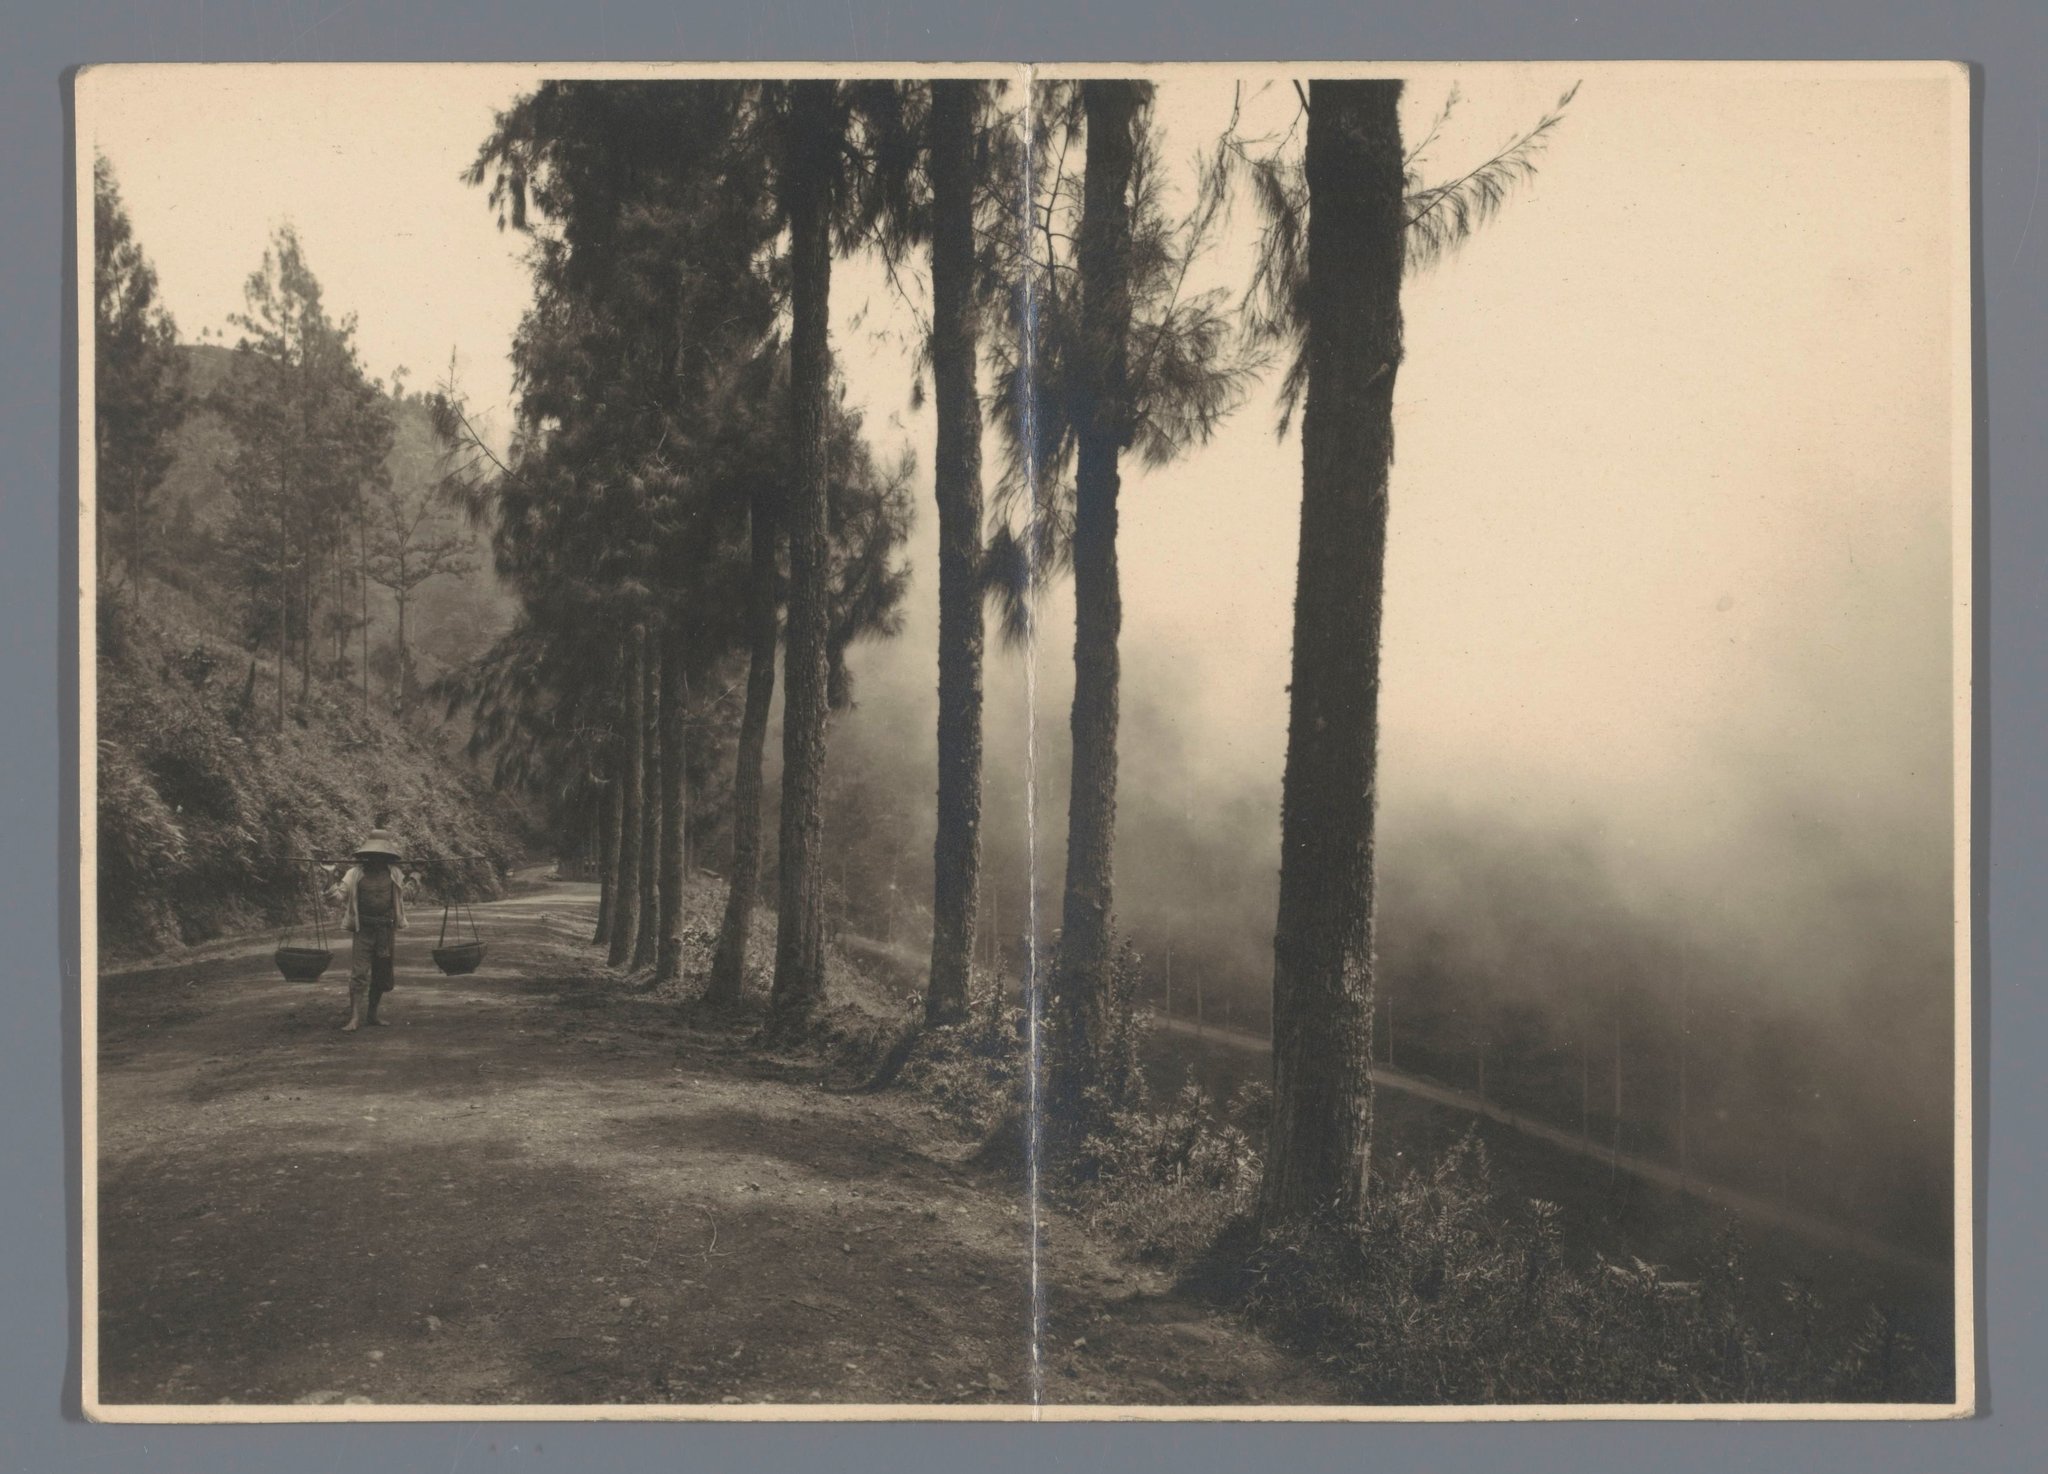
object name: photograph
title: Gezicht op een weg door een berglandschap in Japan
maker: s. satake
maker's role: fotograaf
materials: paper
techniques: gelatin silver print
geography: japan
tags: road, path, mountains, japan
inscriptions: inscription: ‘Original photo/ by S. SATAKE/ TOSARI STUDIO/ reproduction prohibited’, inscription: ‘Geachte Heer van Loenen, (...)’